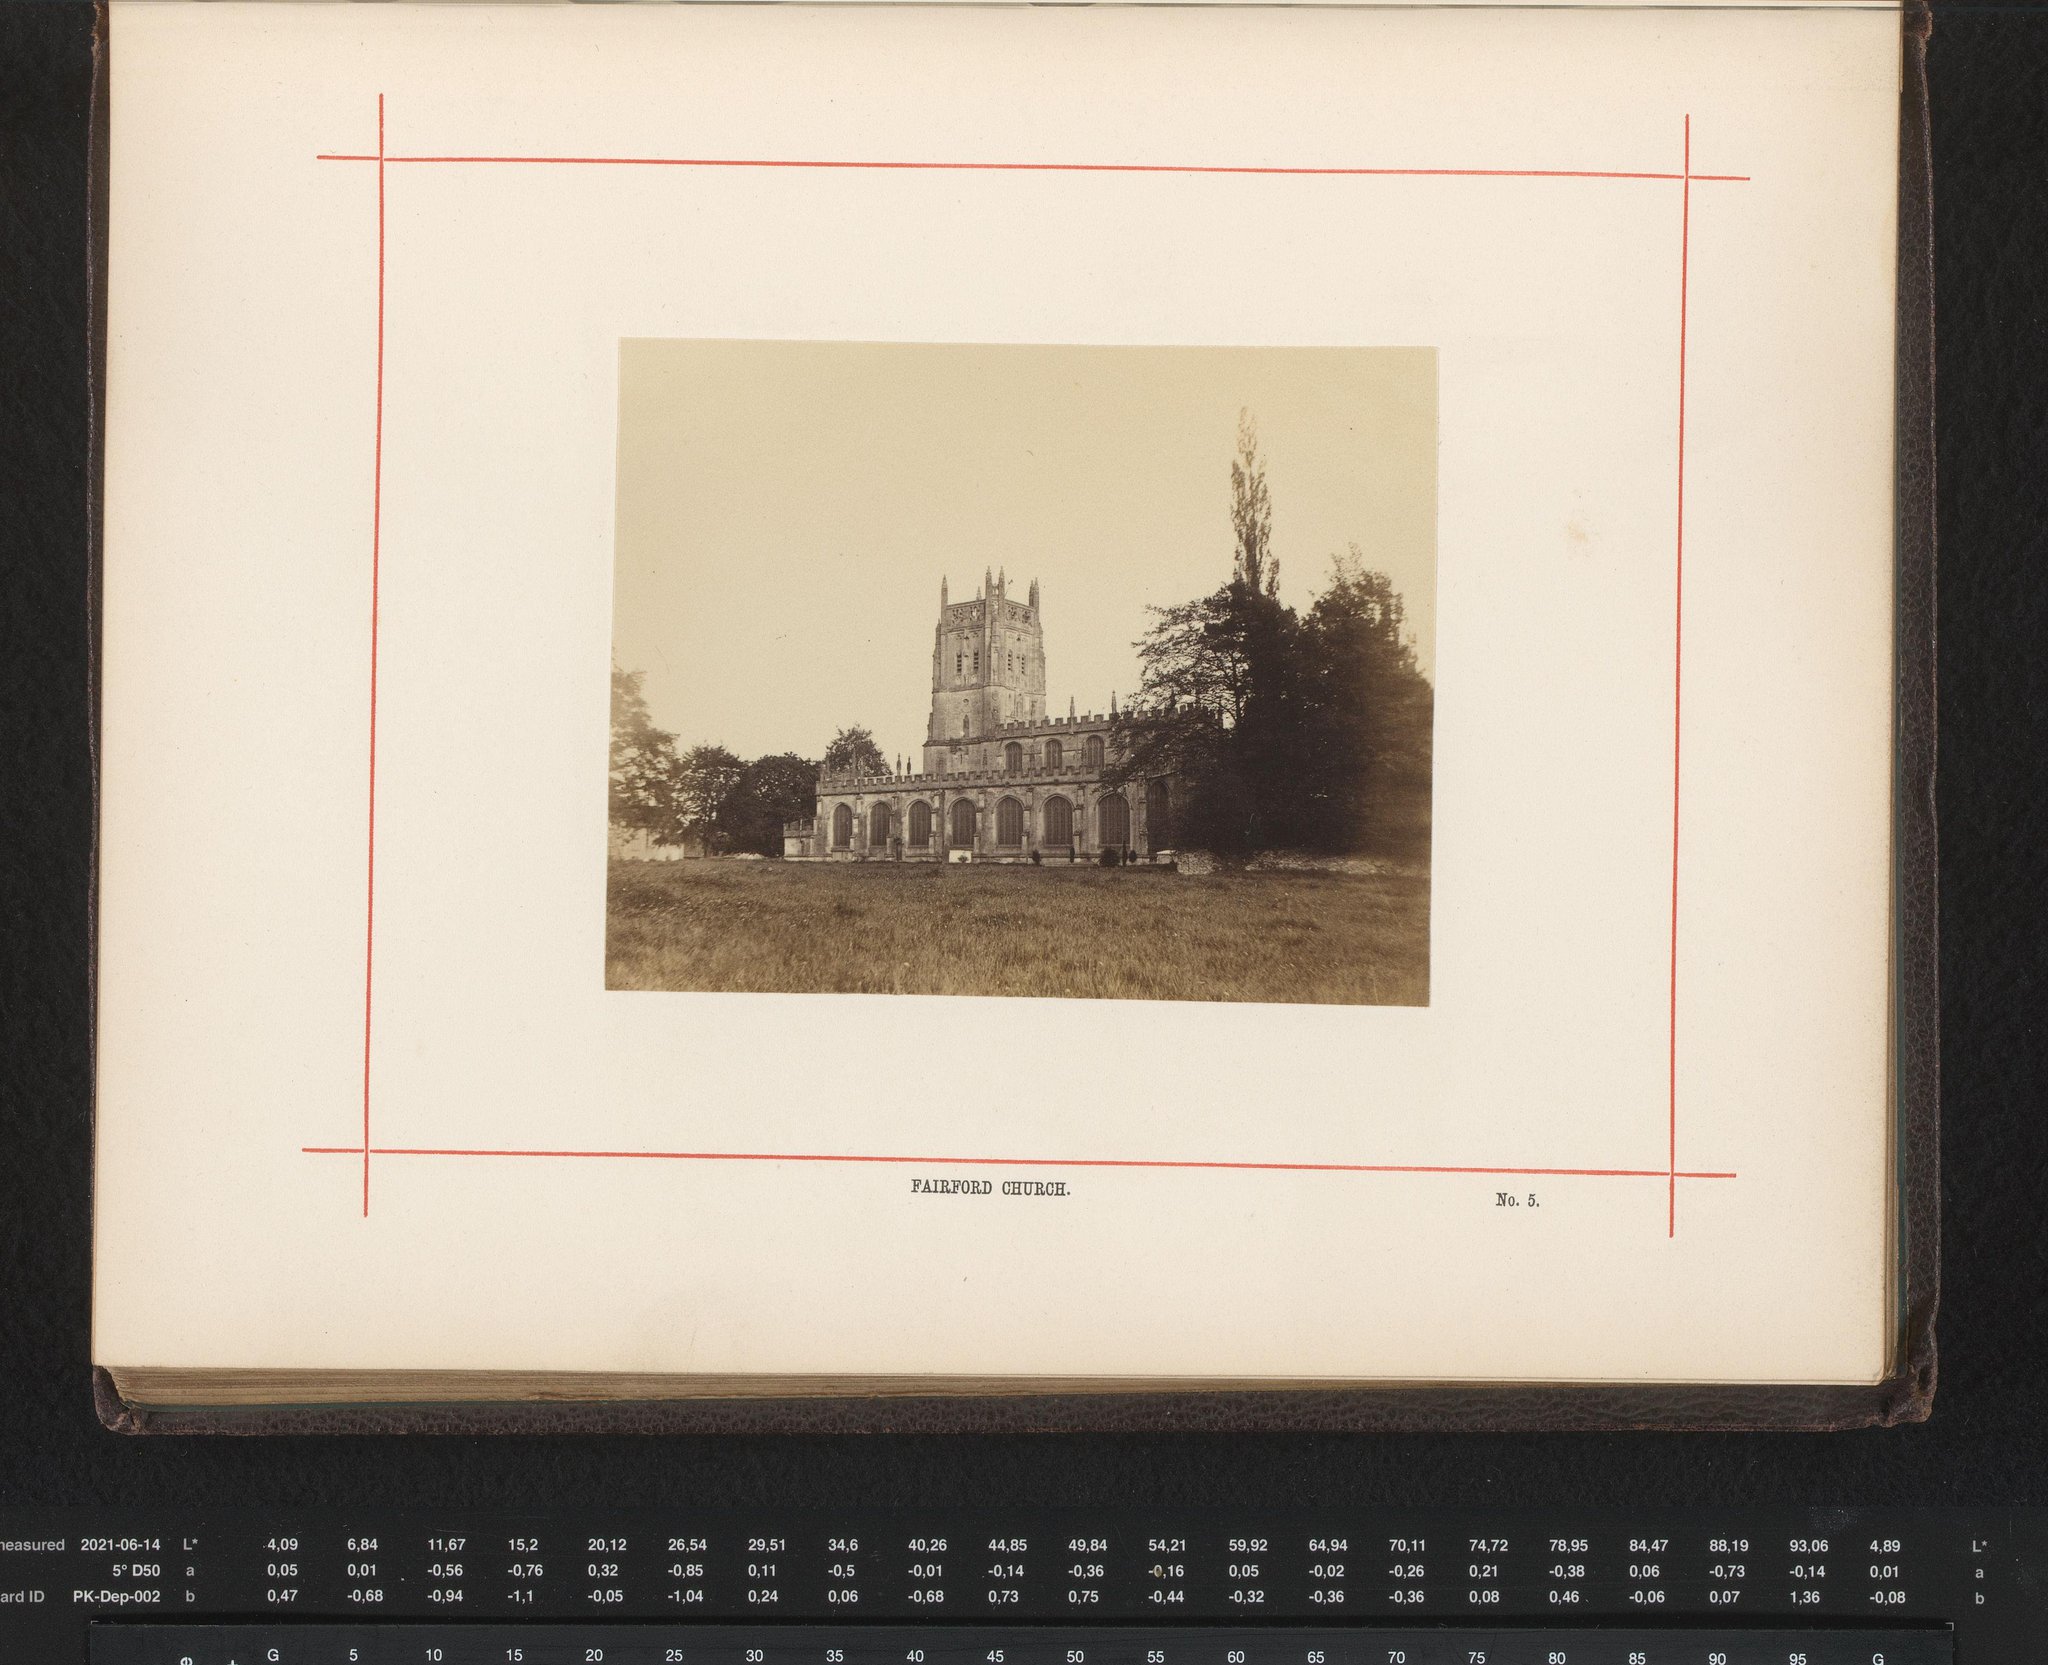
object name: page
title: Fairford Church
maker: william savage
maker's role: fotograaf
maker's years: 1817-1887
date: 1861-1866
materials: paper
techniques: albumen print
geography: fairford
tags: church (exterior)